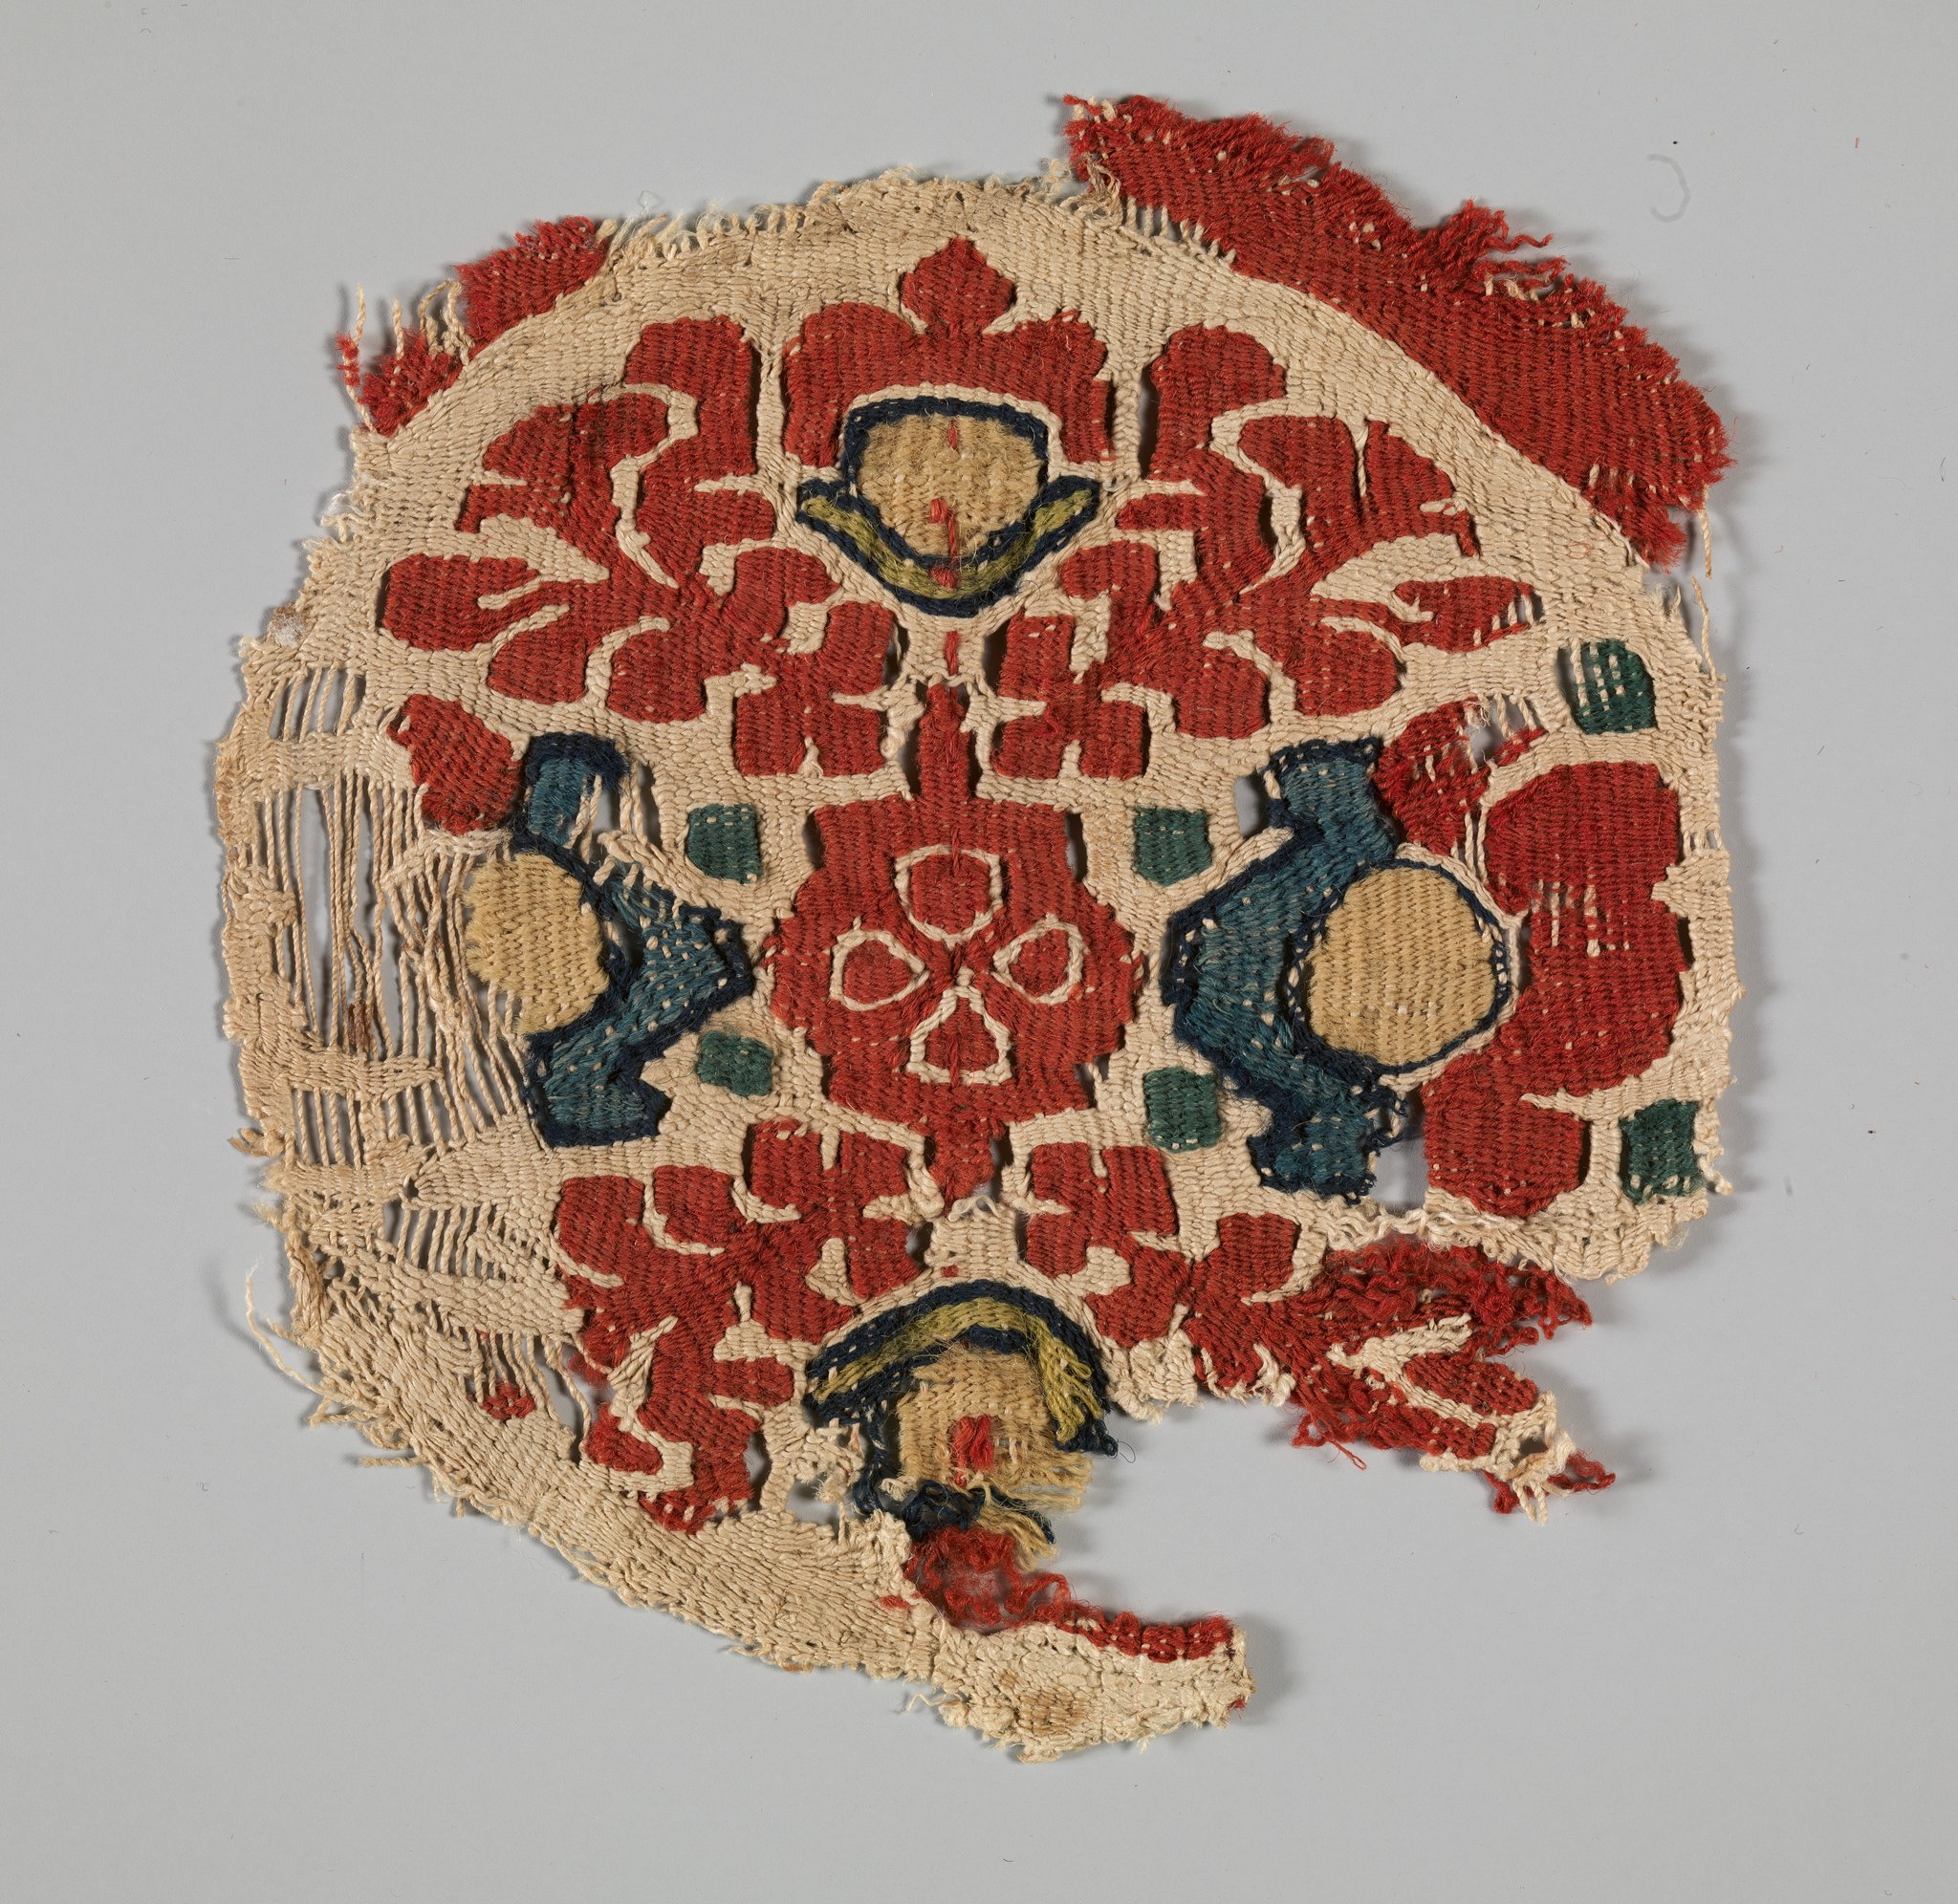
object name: textile fragment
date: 401-500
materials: linen, wool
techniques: weave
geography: egypt